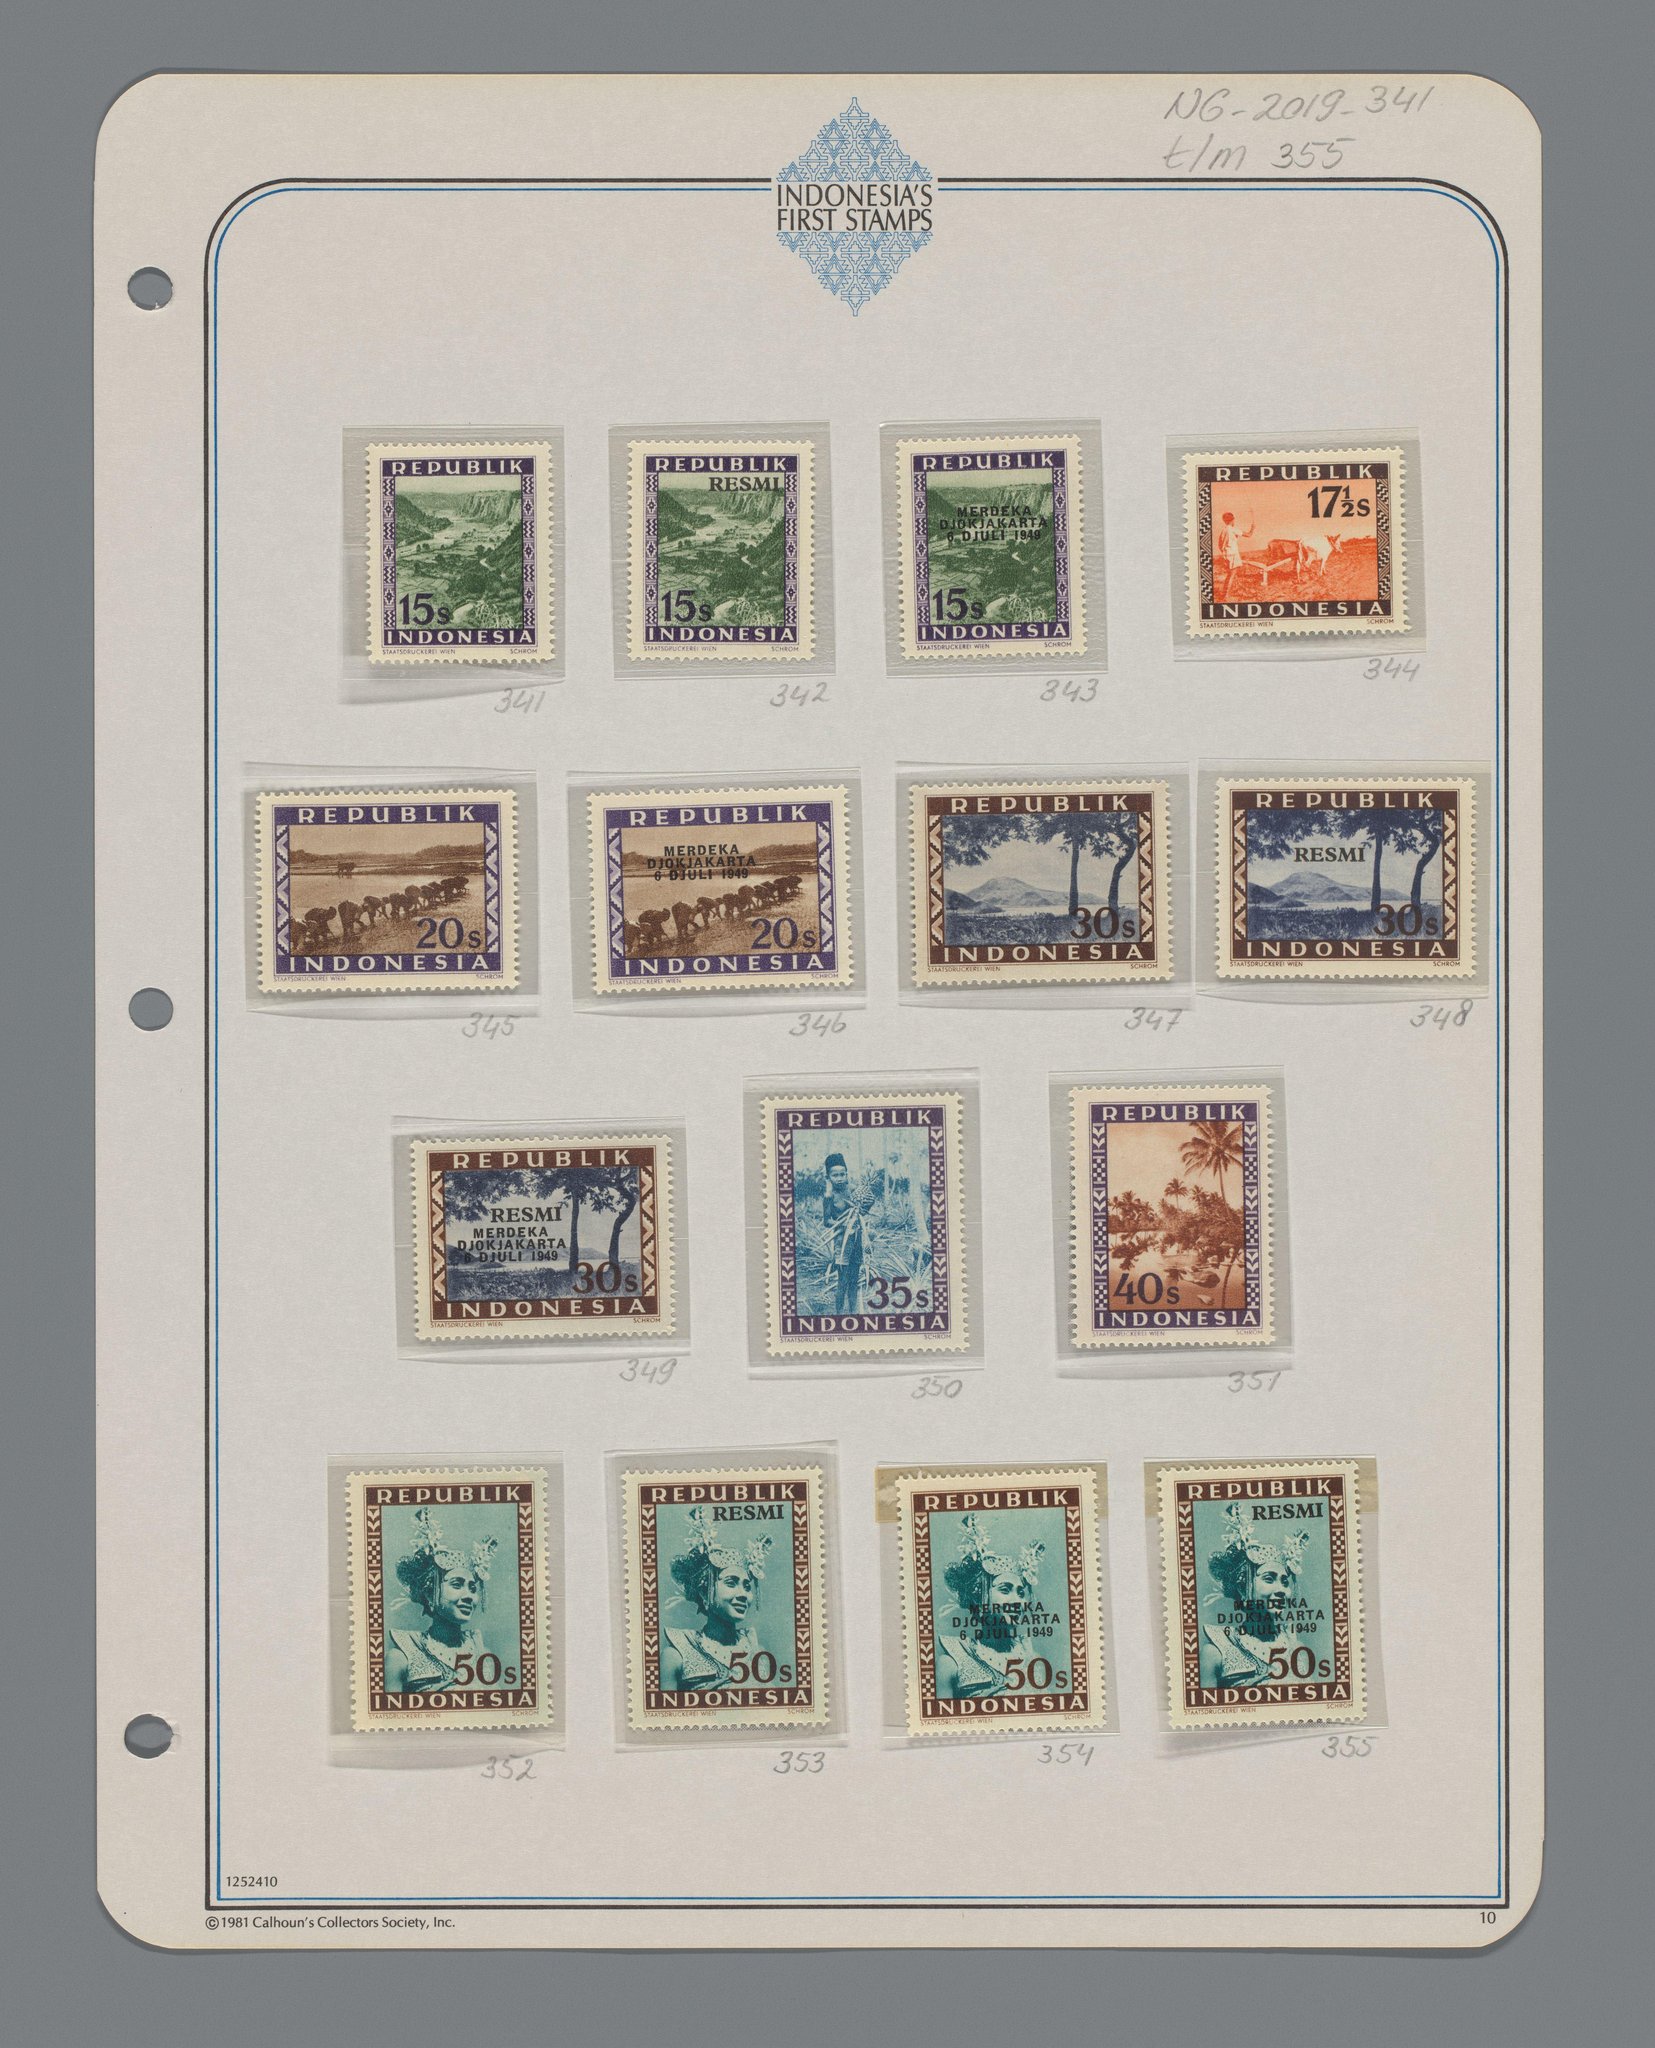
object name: postage stamp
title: Postzegel Republik Indonesia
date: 1949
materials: paper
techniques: photoaquatint, engraving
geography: vienna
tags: indonesia